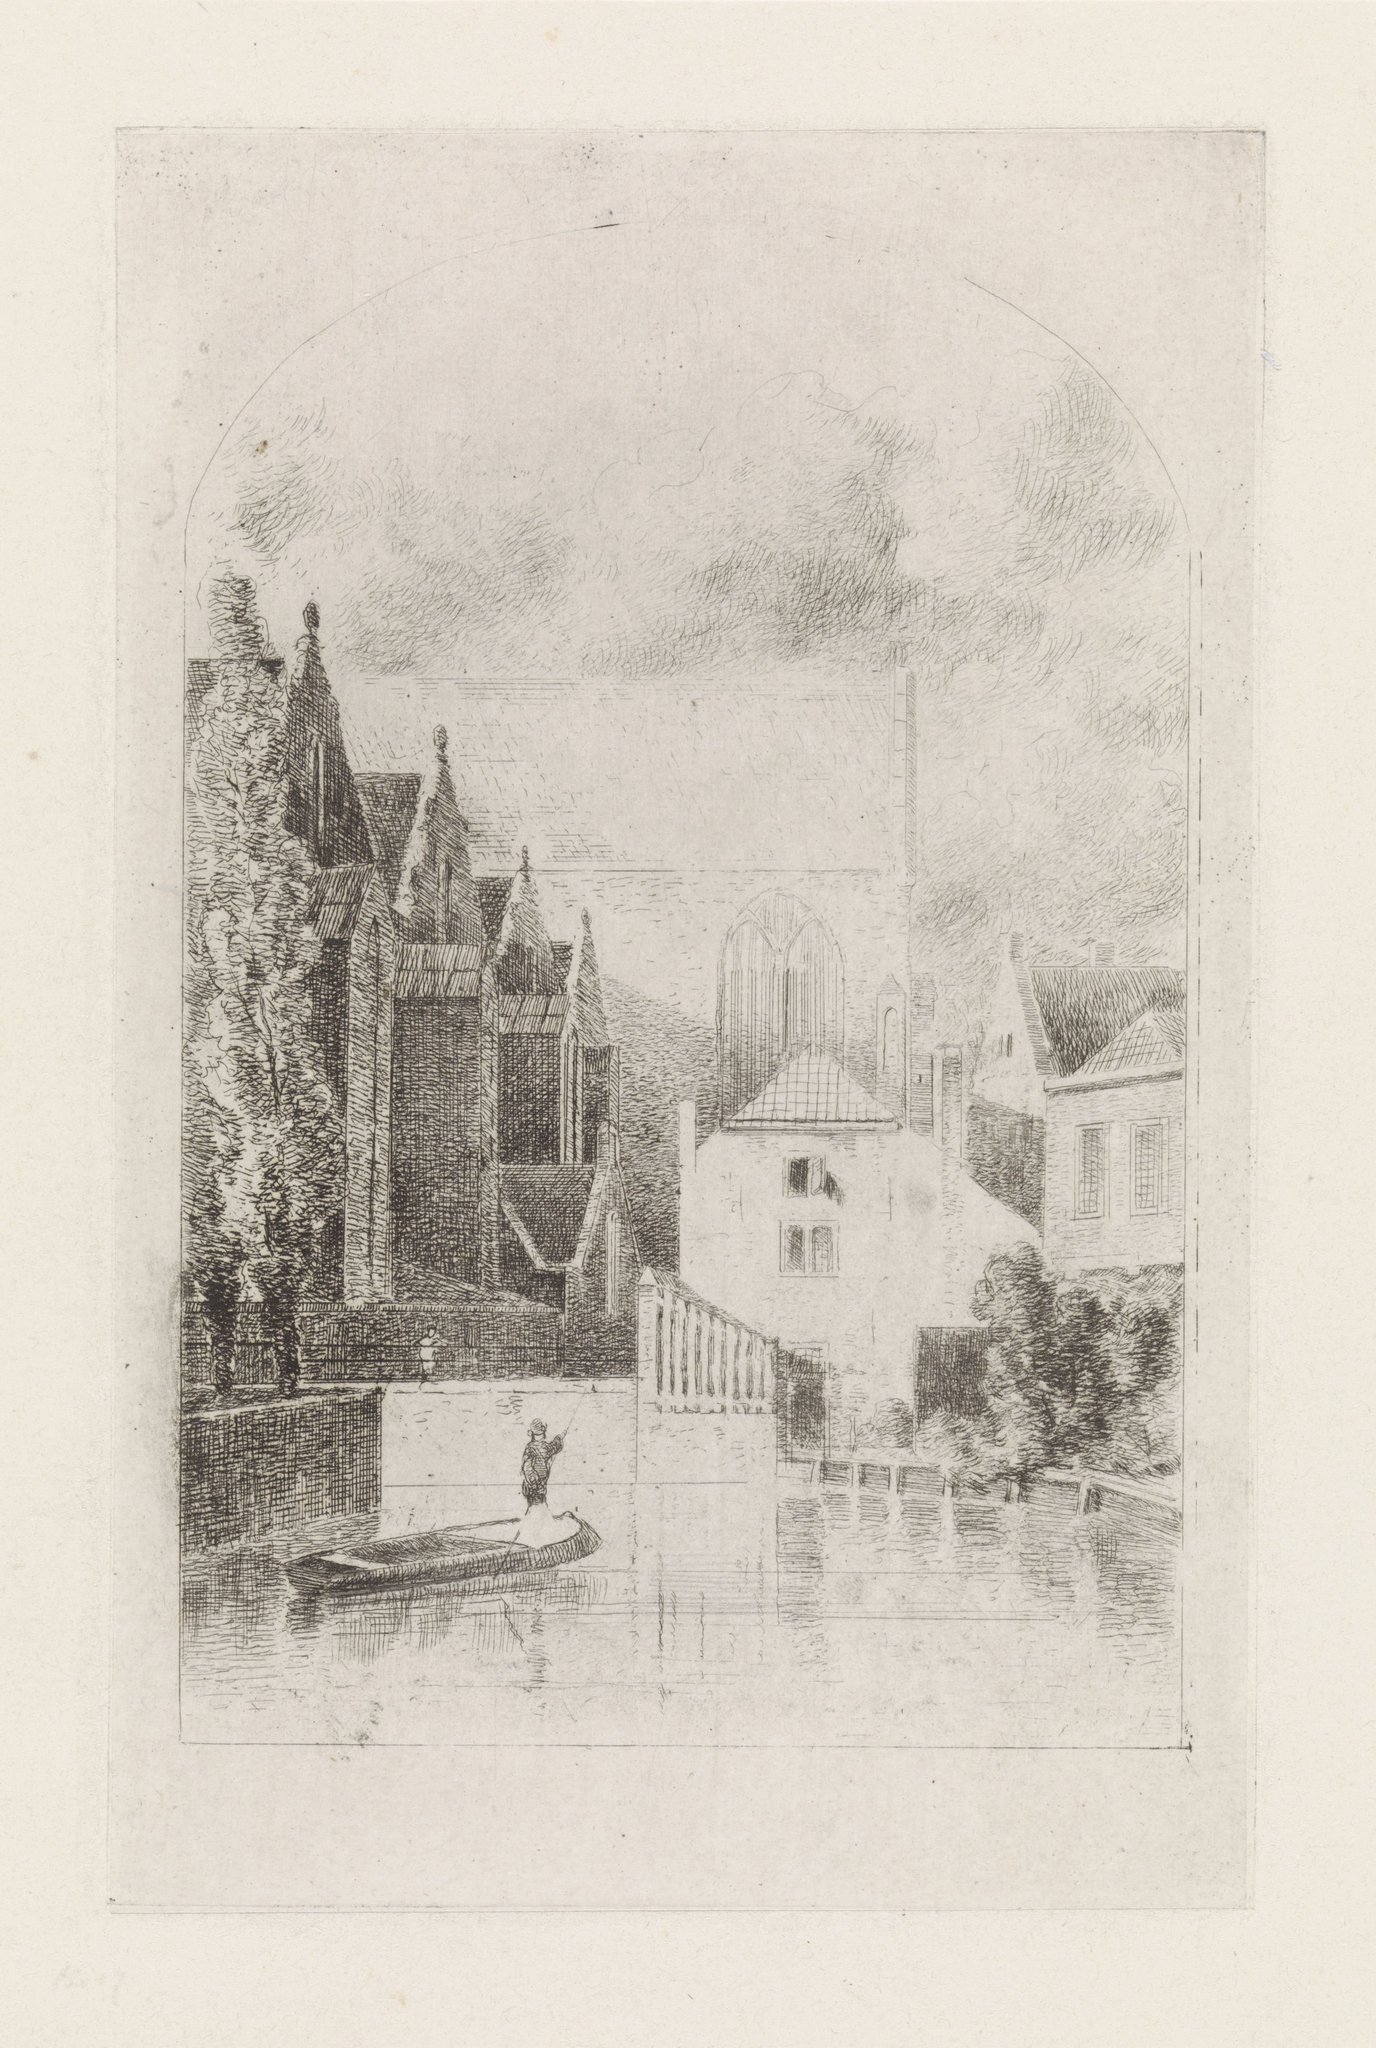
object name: print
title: Man op een schuit in een gracht tussen huizen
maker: gijsbertus johannes verspuy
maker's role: print maker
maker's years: 1823-1862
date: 1858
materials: paper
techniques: etching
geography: netherlands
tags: canals, waters (in village), poling, punting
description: Een man boomt met een vaarboom een schuit voort in een gracht tussen huizen. In het midden een kerkgebouw.